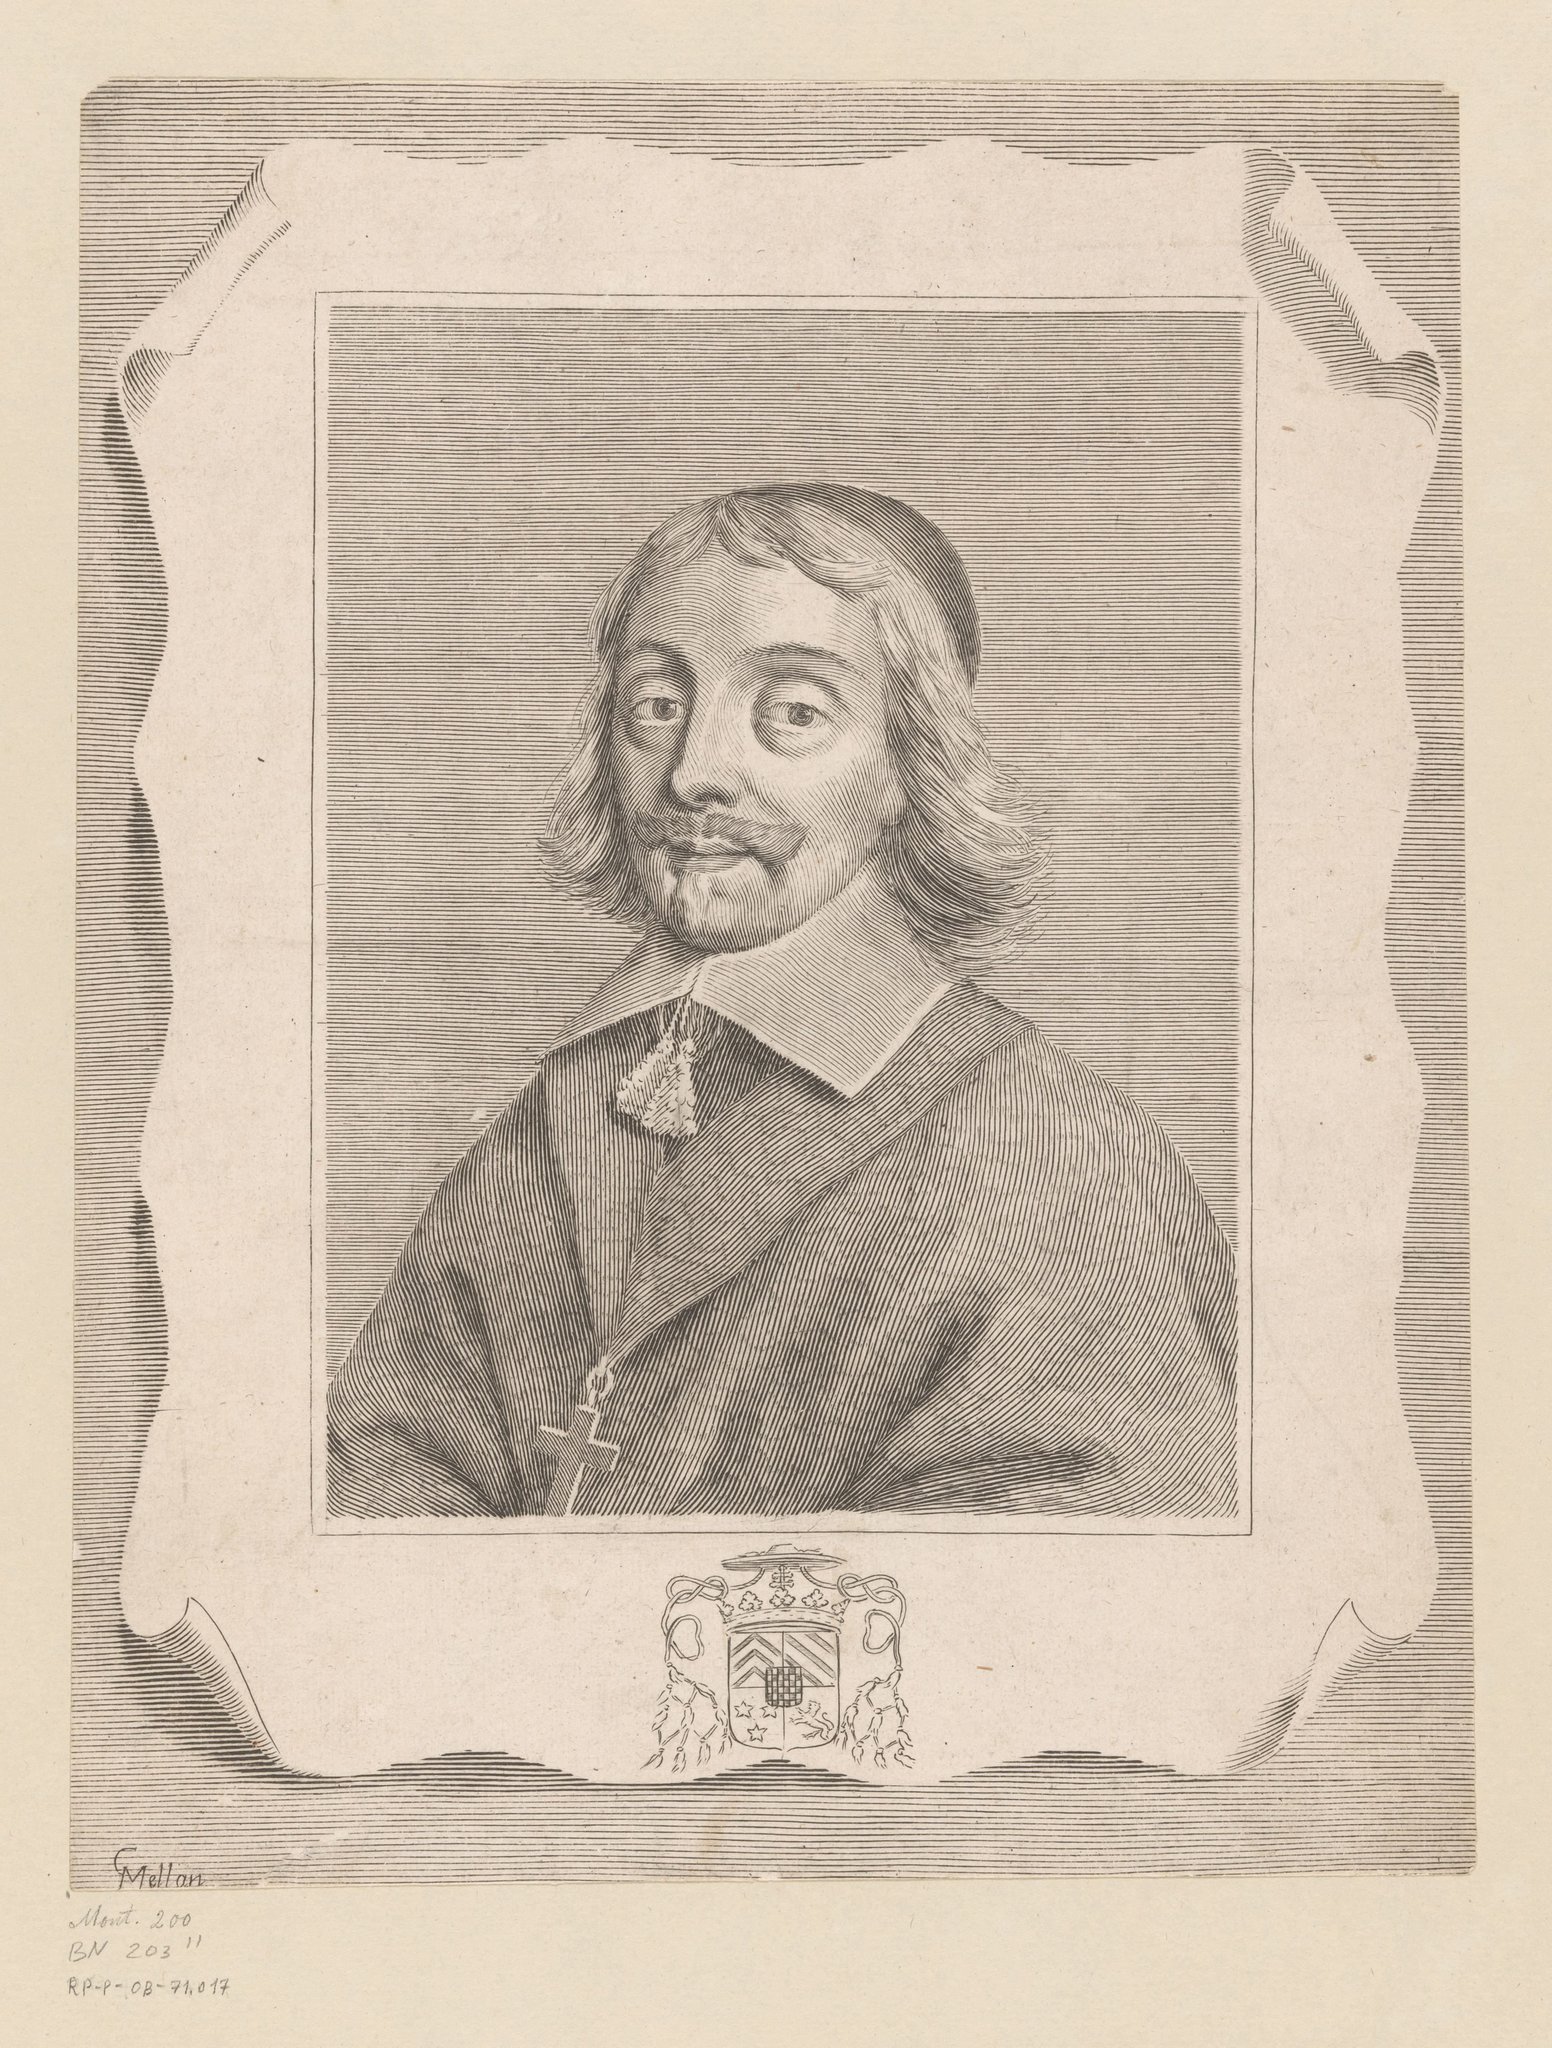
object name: print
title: Portret van Anne de Lévis, hertog van Ventadour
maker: claude mellan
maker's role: draughtsman, print maker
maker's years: 1598-1688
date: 1649-1688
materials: paper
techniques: engraving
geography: france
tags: clergyman, historical persons, armorial bearing, heraldry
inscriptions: collector's mark: Lugt 240